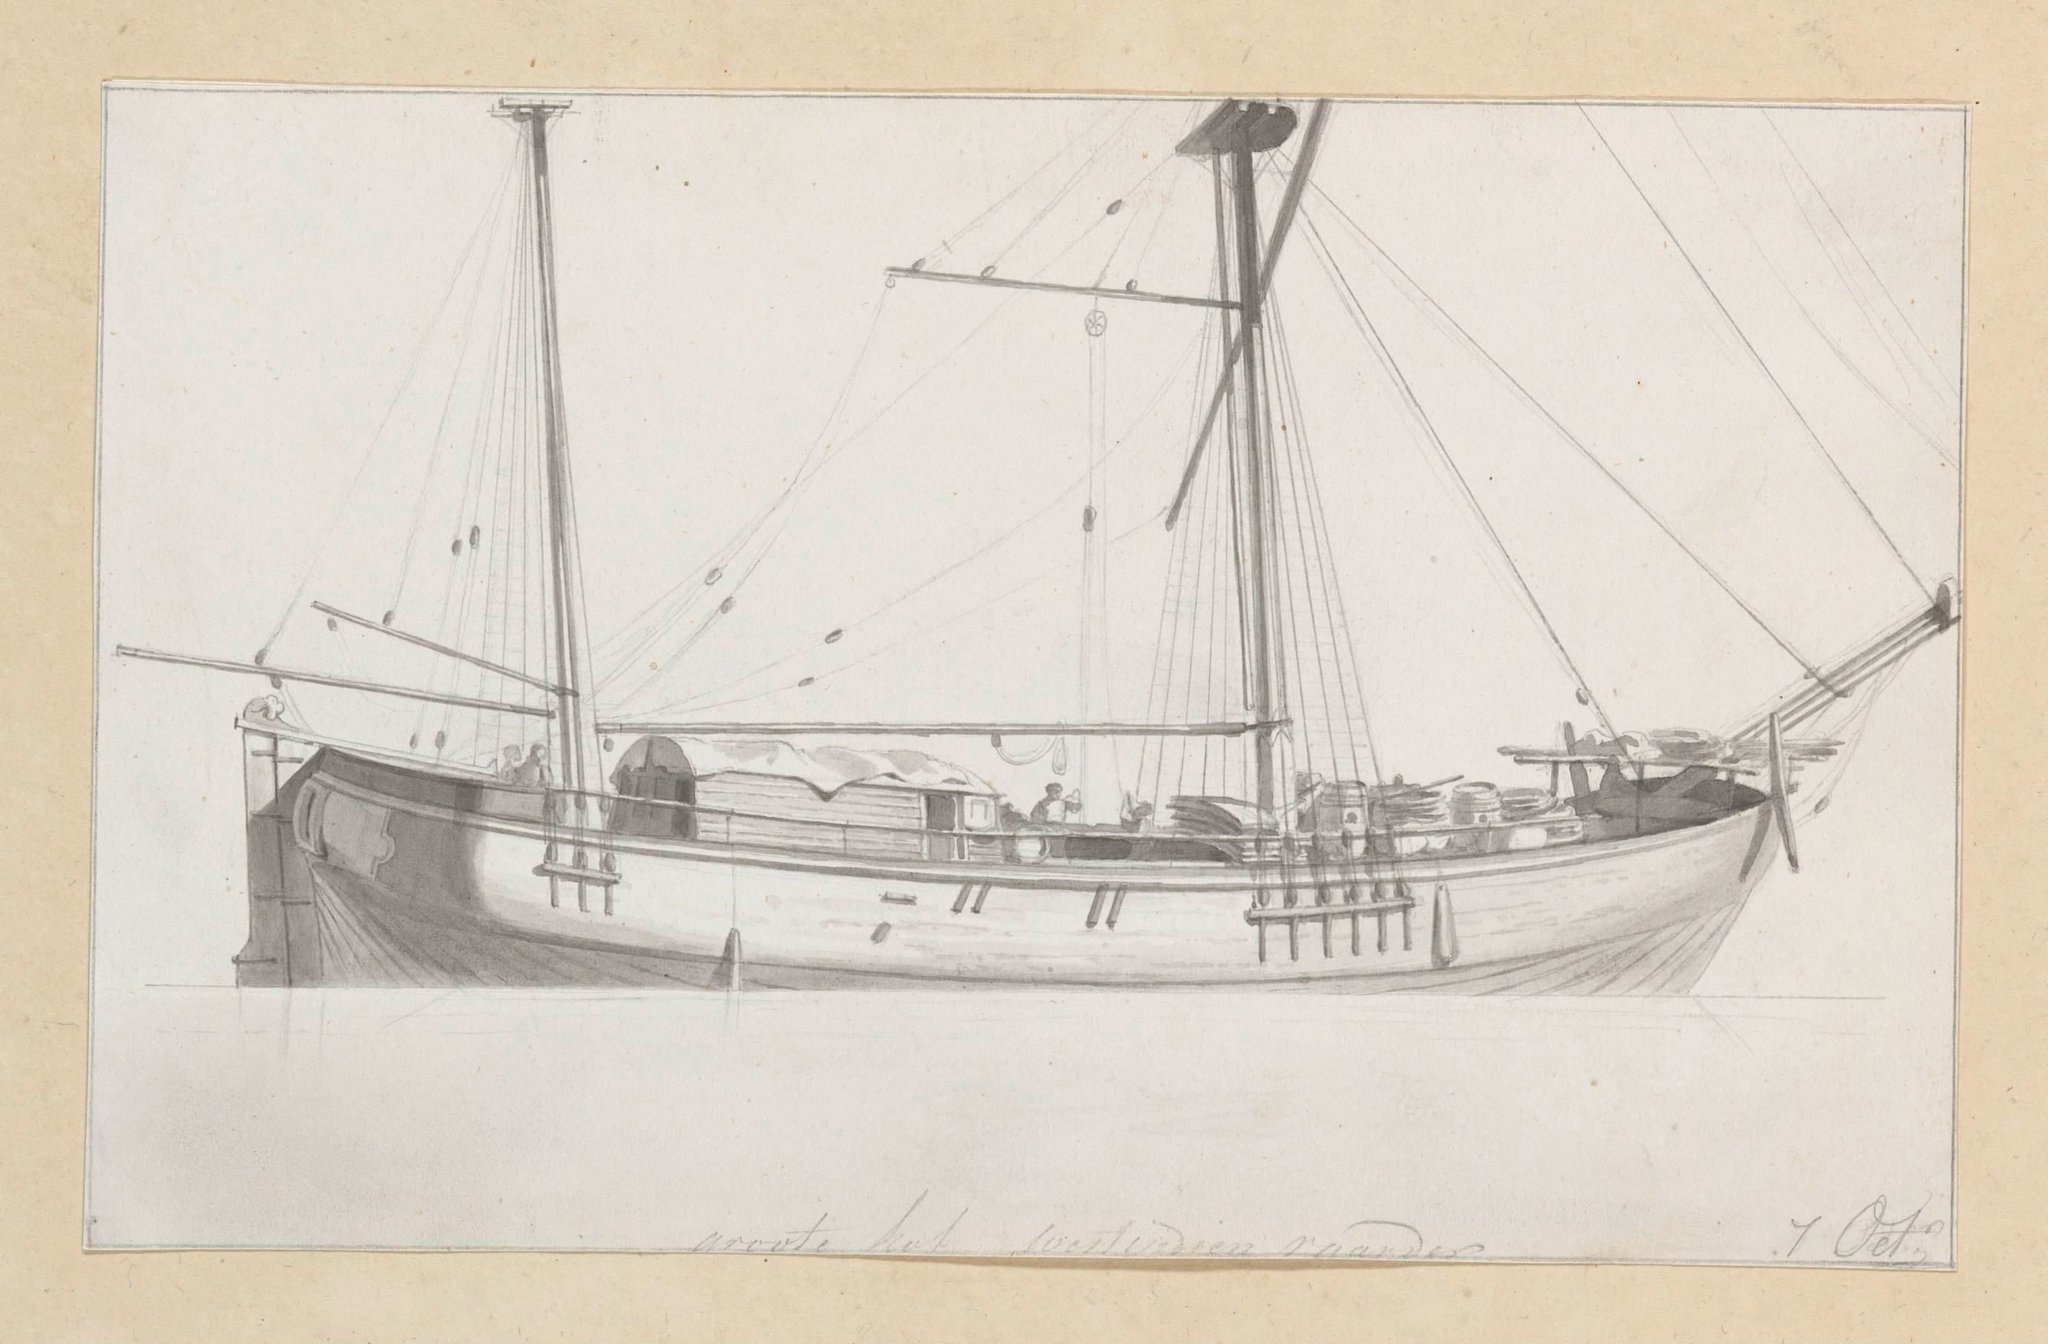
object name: drawing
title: West-Indiëvaarder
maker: hendrik abraham klinkhamer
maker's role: draughtsman, painter, print maker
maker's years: 1810-1872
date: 1820-1872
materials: paper, pencil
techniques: brush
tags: sailing-ship, sailing-boat (westindiaman)